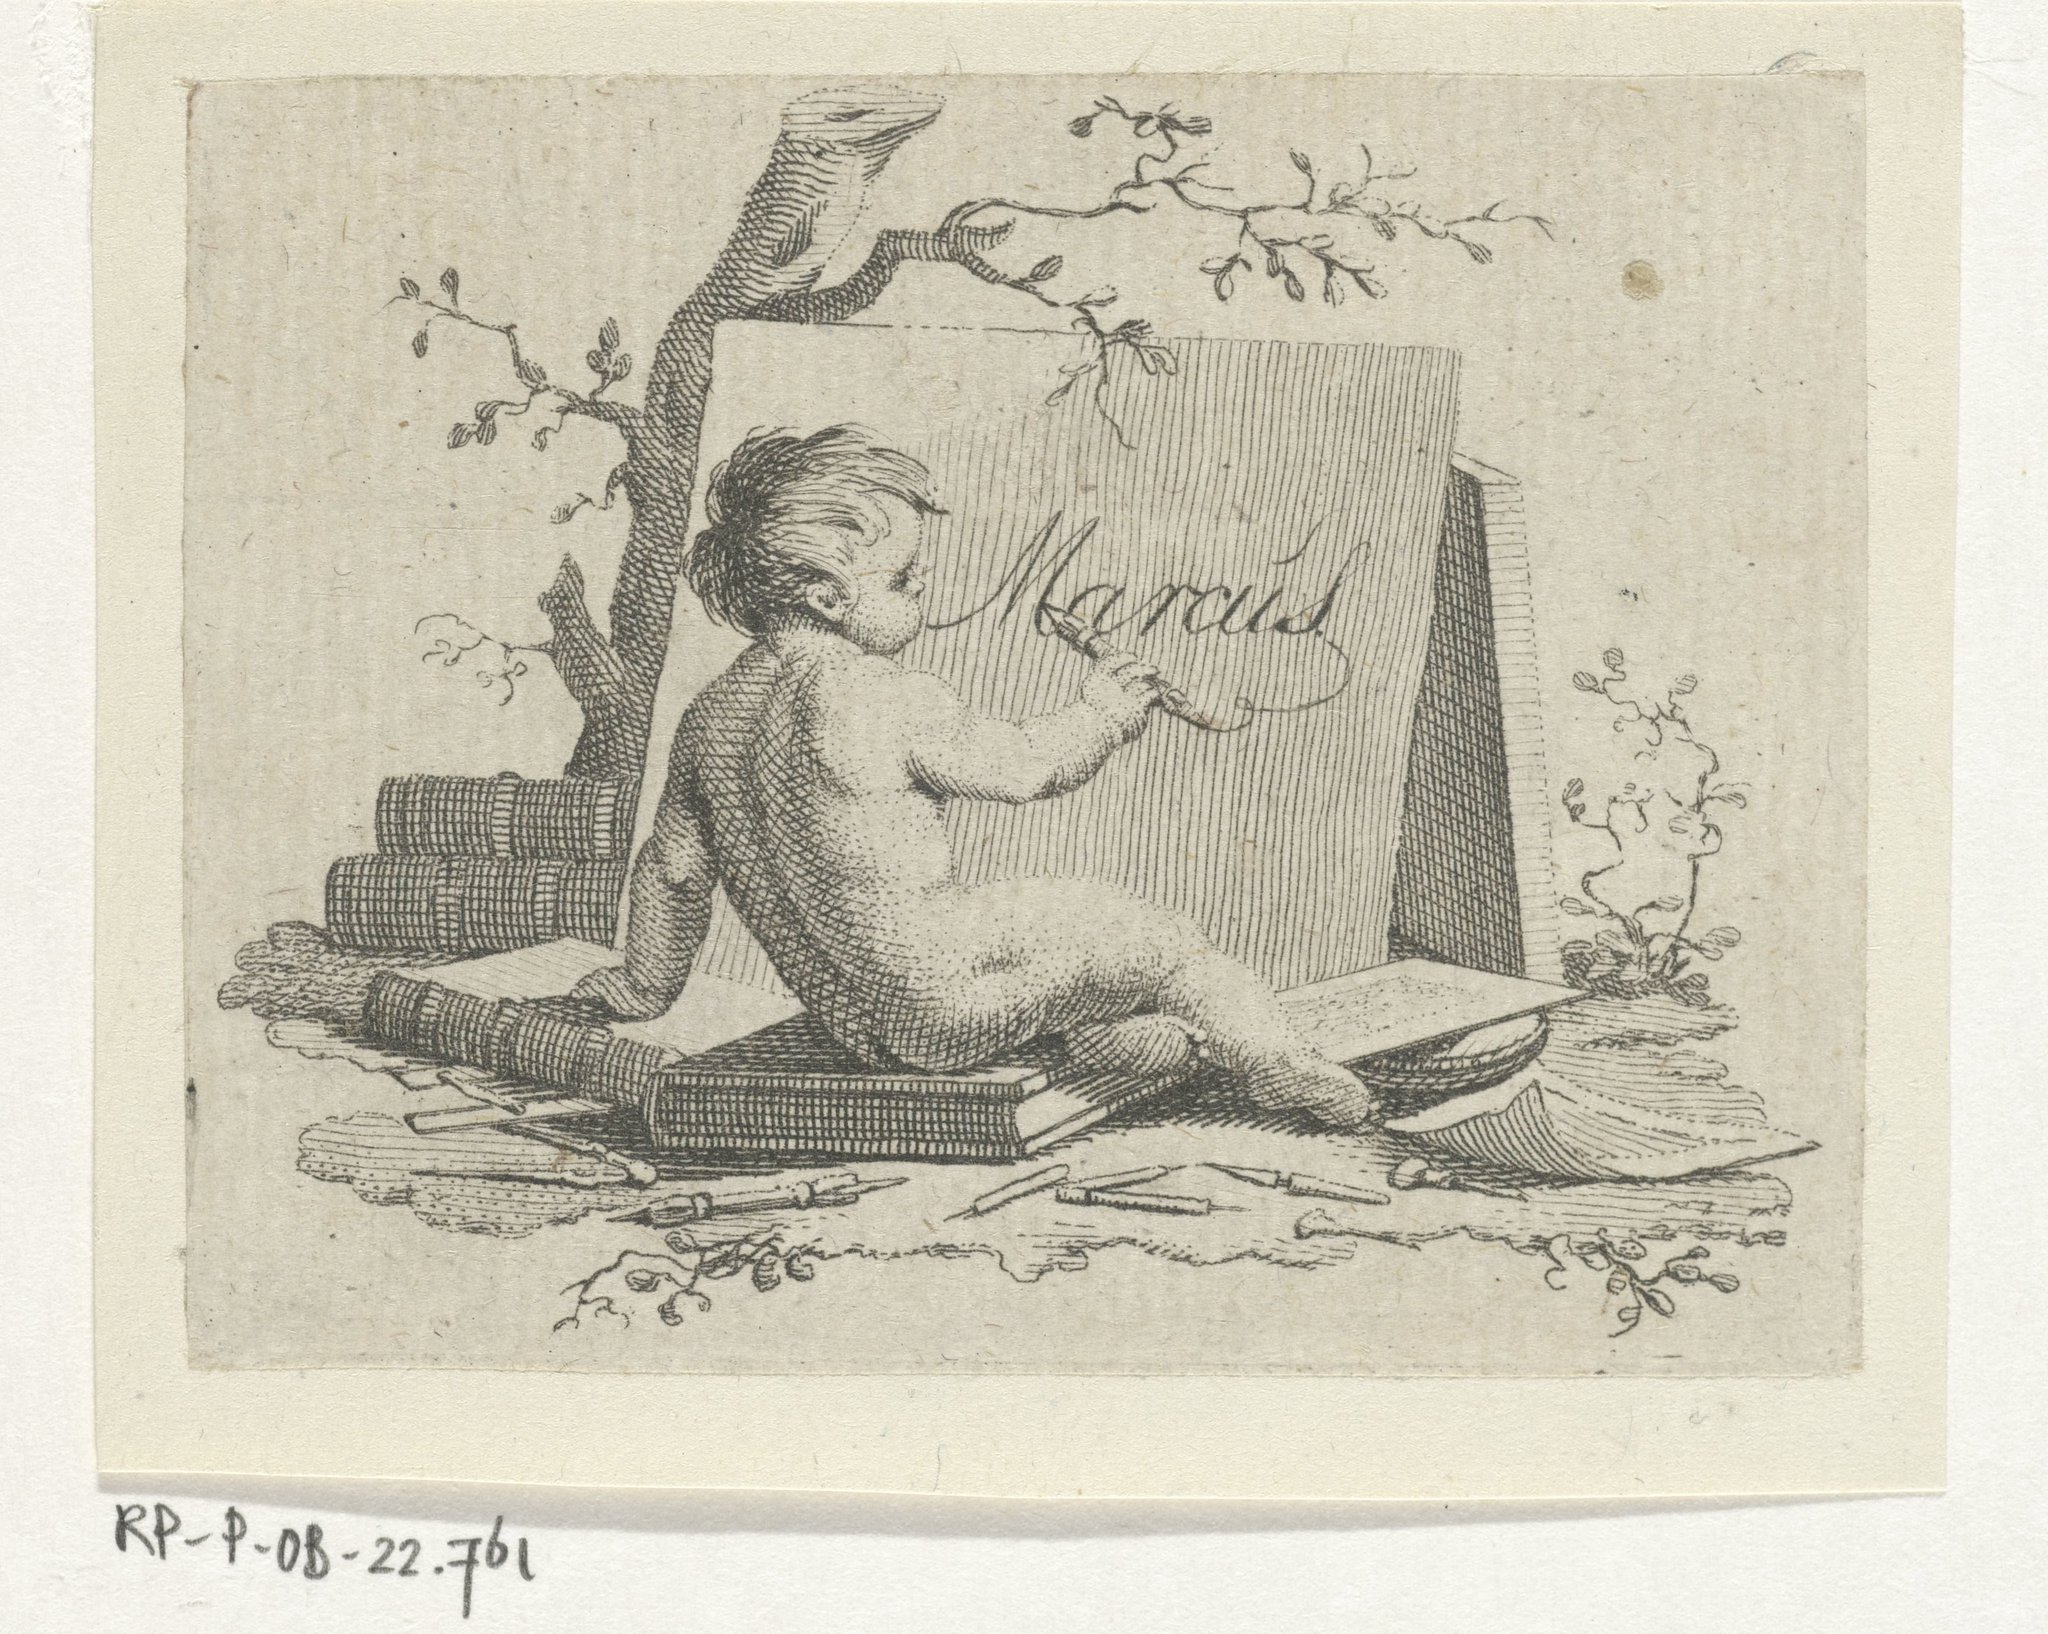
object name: print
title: Schrijvende putto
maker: jacob ernst marcus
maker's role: draughtsman, print maker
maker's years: 1774-1826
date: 1784-1826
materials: paper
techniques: etching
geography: amsterdam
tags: writing tablets, tools, implements of graphic artist, book, cupids: 'amores', 'amoretti', 'putti'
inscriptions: collector's mark: Lugt 2760, collector's mark: Lugt 2228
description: Een door boeken omringde putto schrijft de naam Marcus op een schrijftablet. Op de grond liggen etsnaalden, een burijn en een passer.